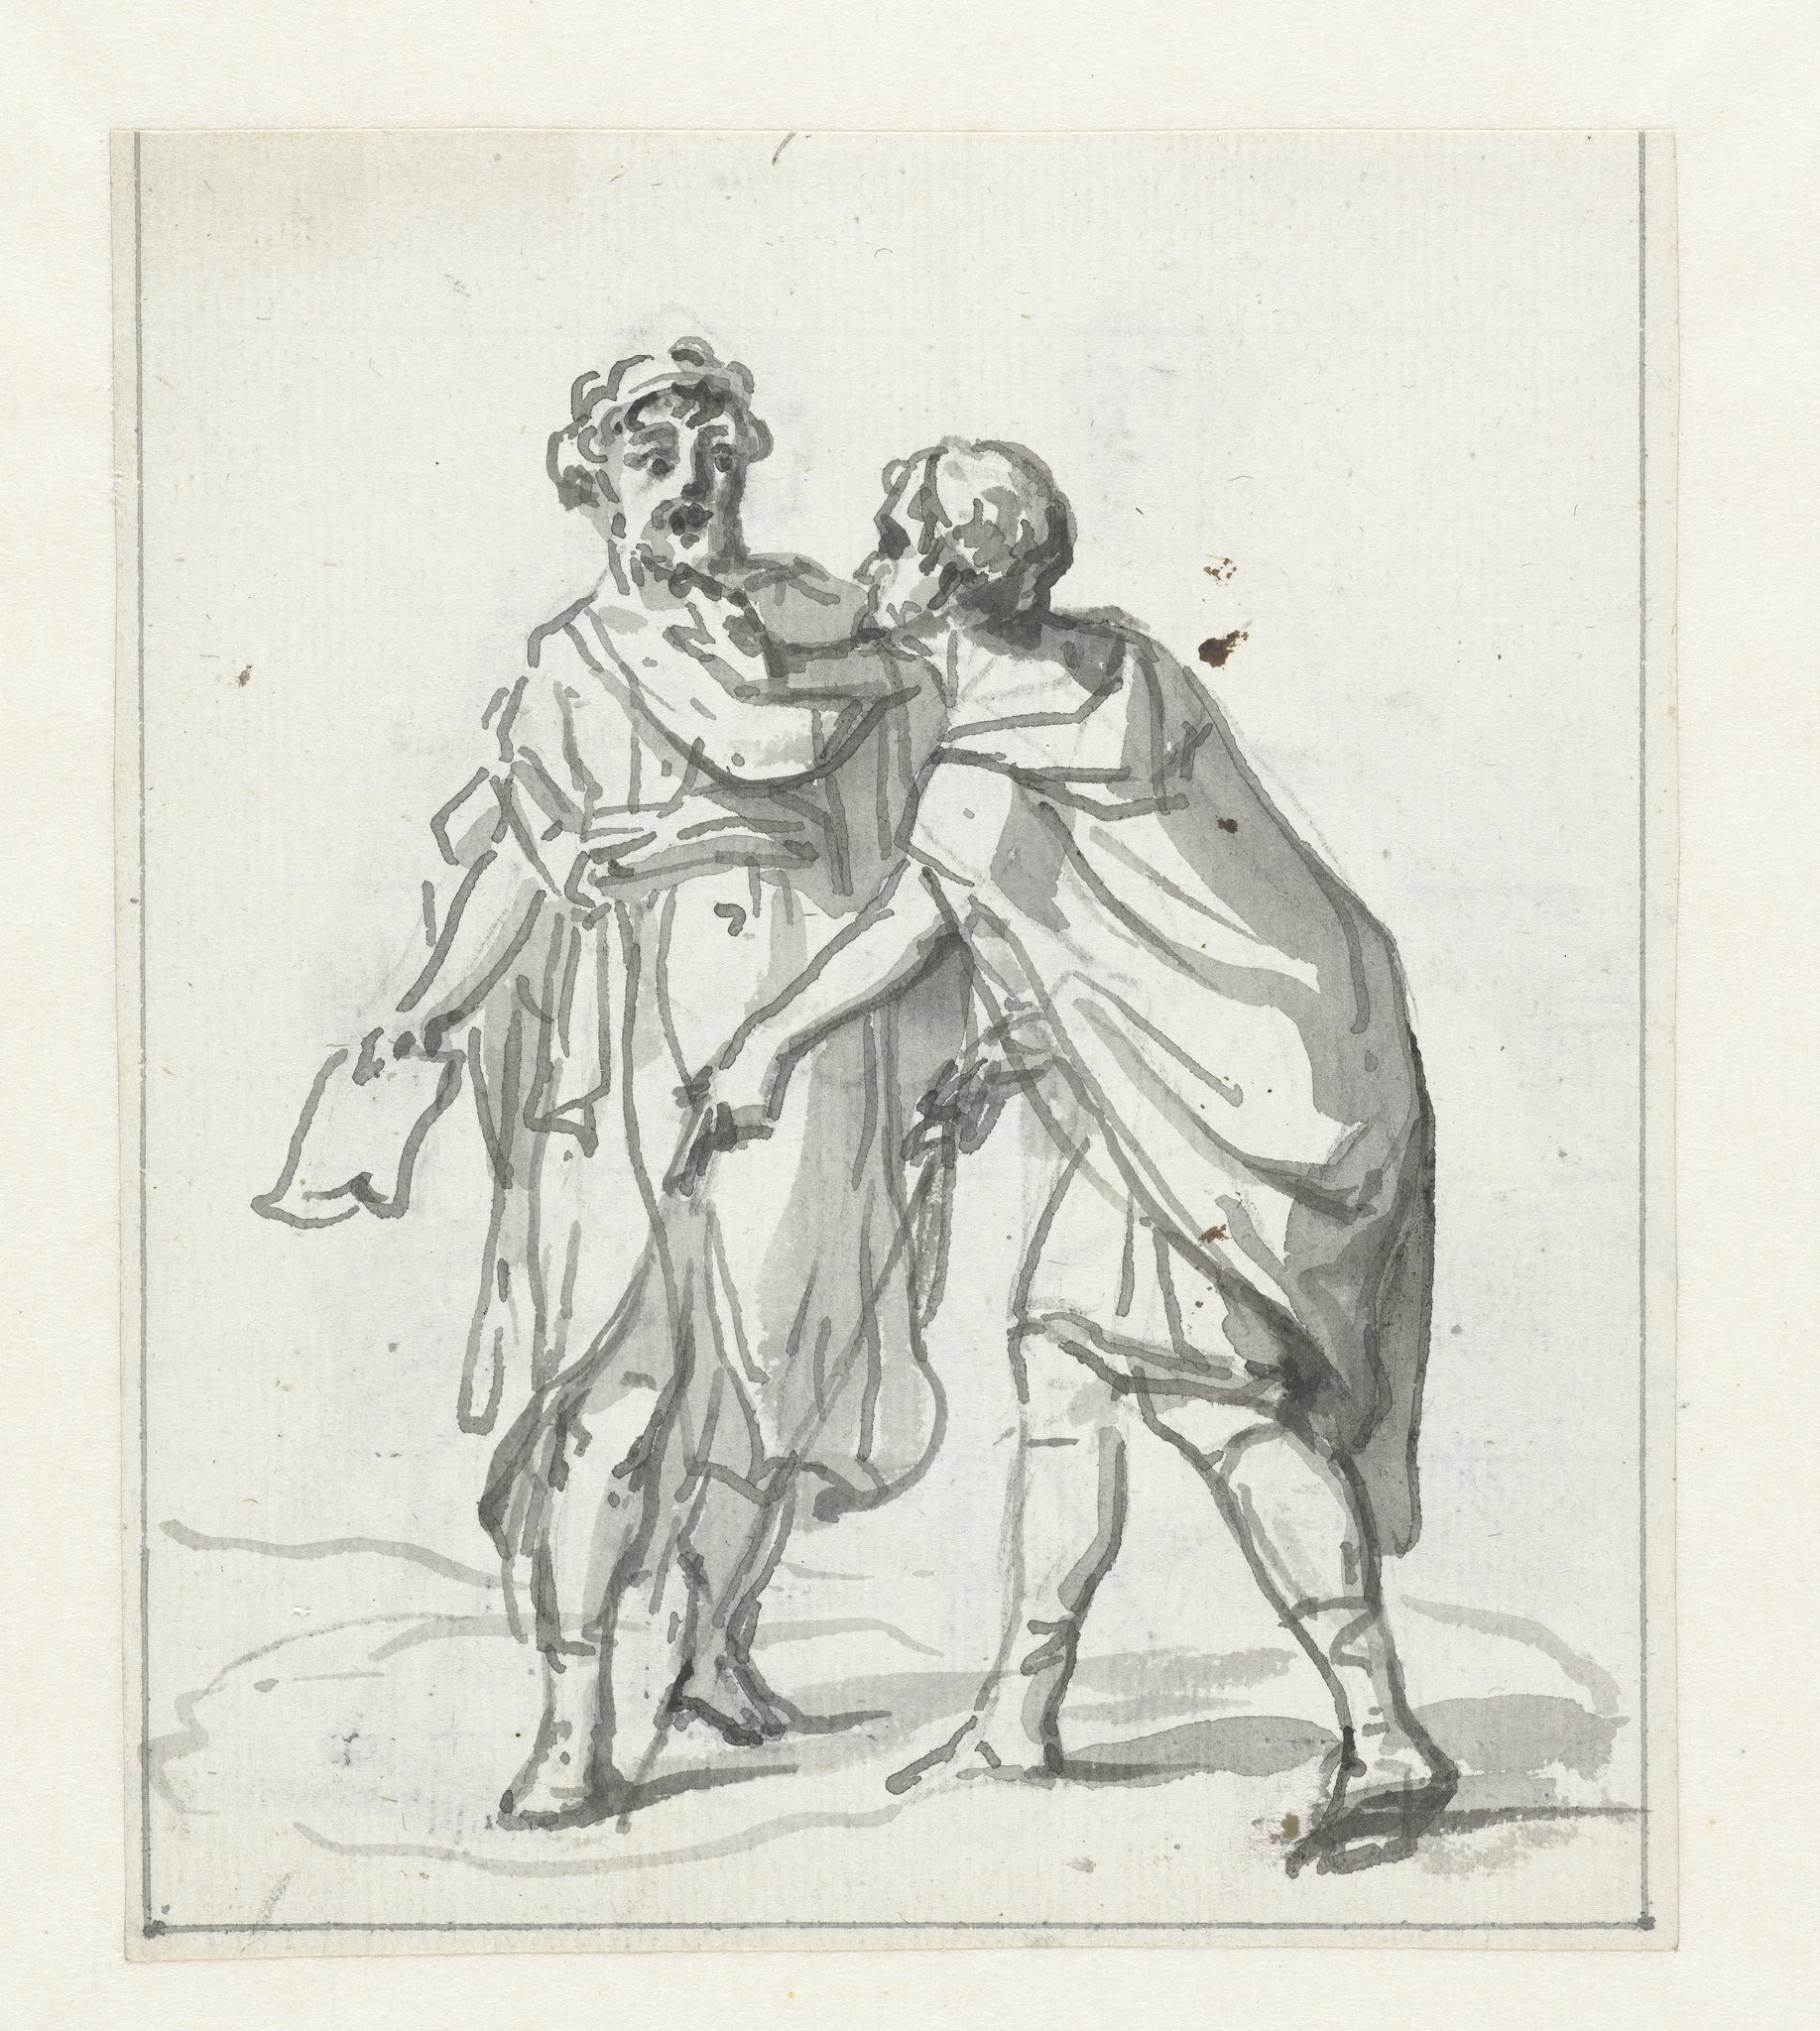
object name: drawing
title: Laenas trekt een cirkel in het zand rond Antiochus IV Epiphanes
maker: jurriaan andriessen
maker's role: draughtsman, painter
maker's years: 1742-1819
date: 1752-1819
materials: graphite, ink, paper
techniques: brush, pen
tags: the consul c. popilius laenas, commissioned by the roman senate to order antiochus iv epiphanes to abstain from war, with his staff draws a circle around the monarch and asks him not to go beyond it before answering